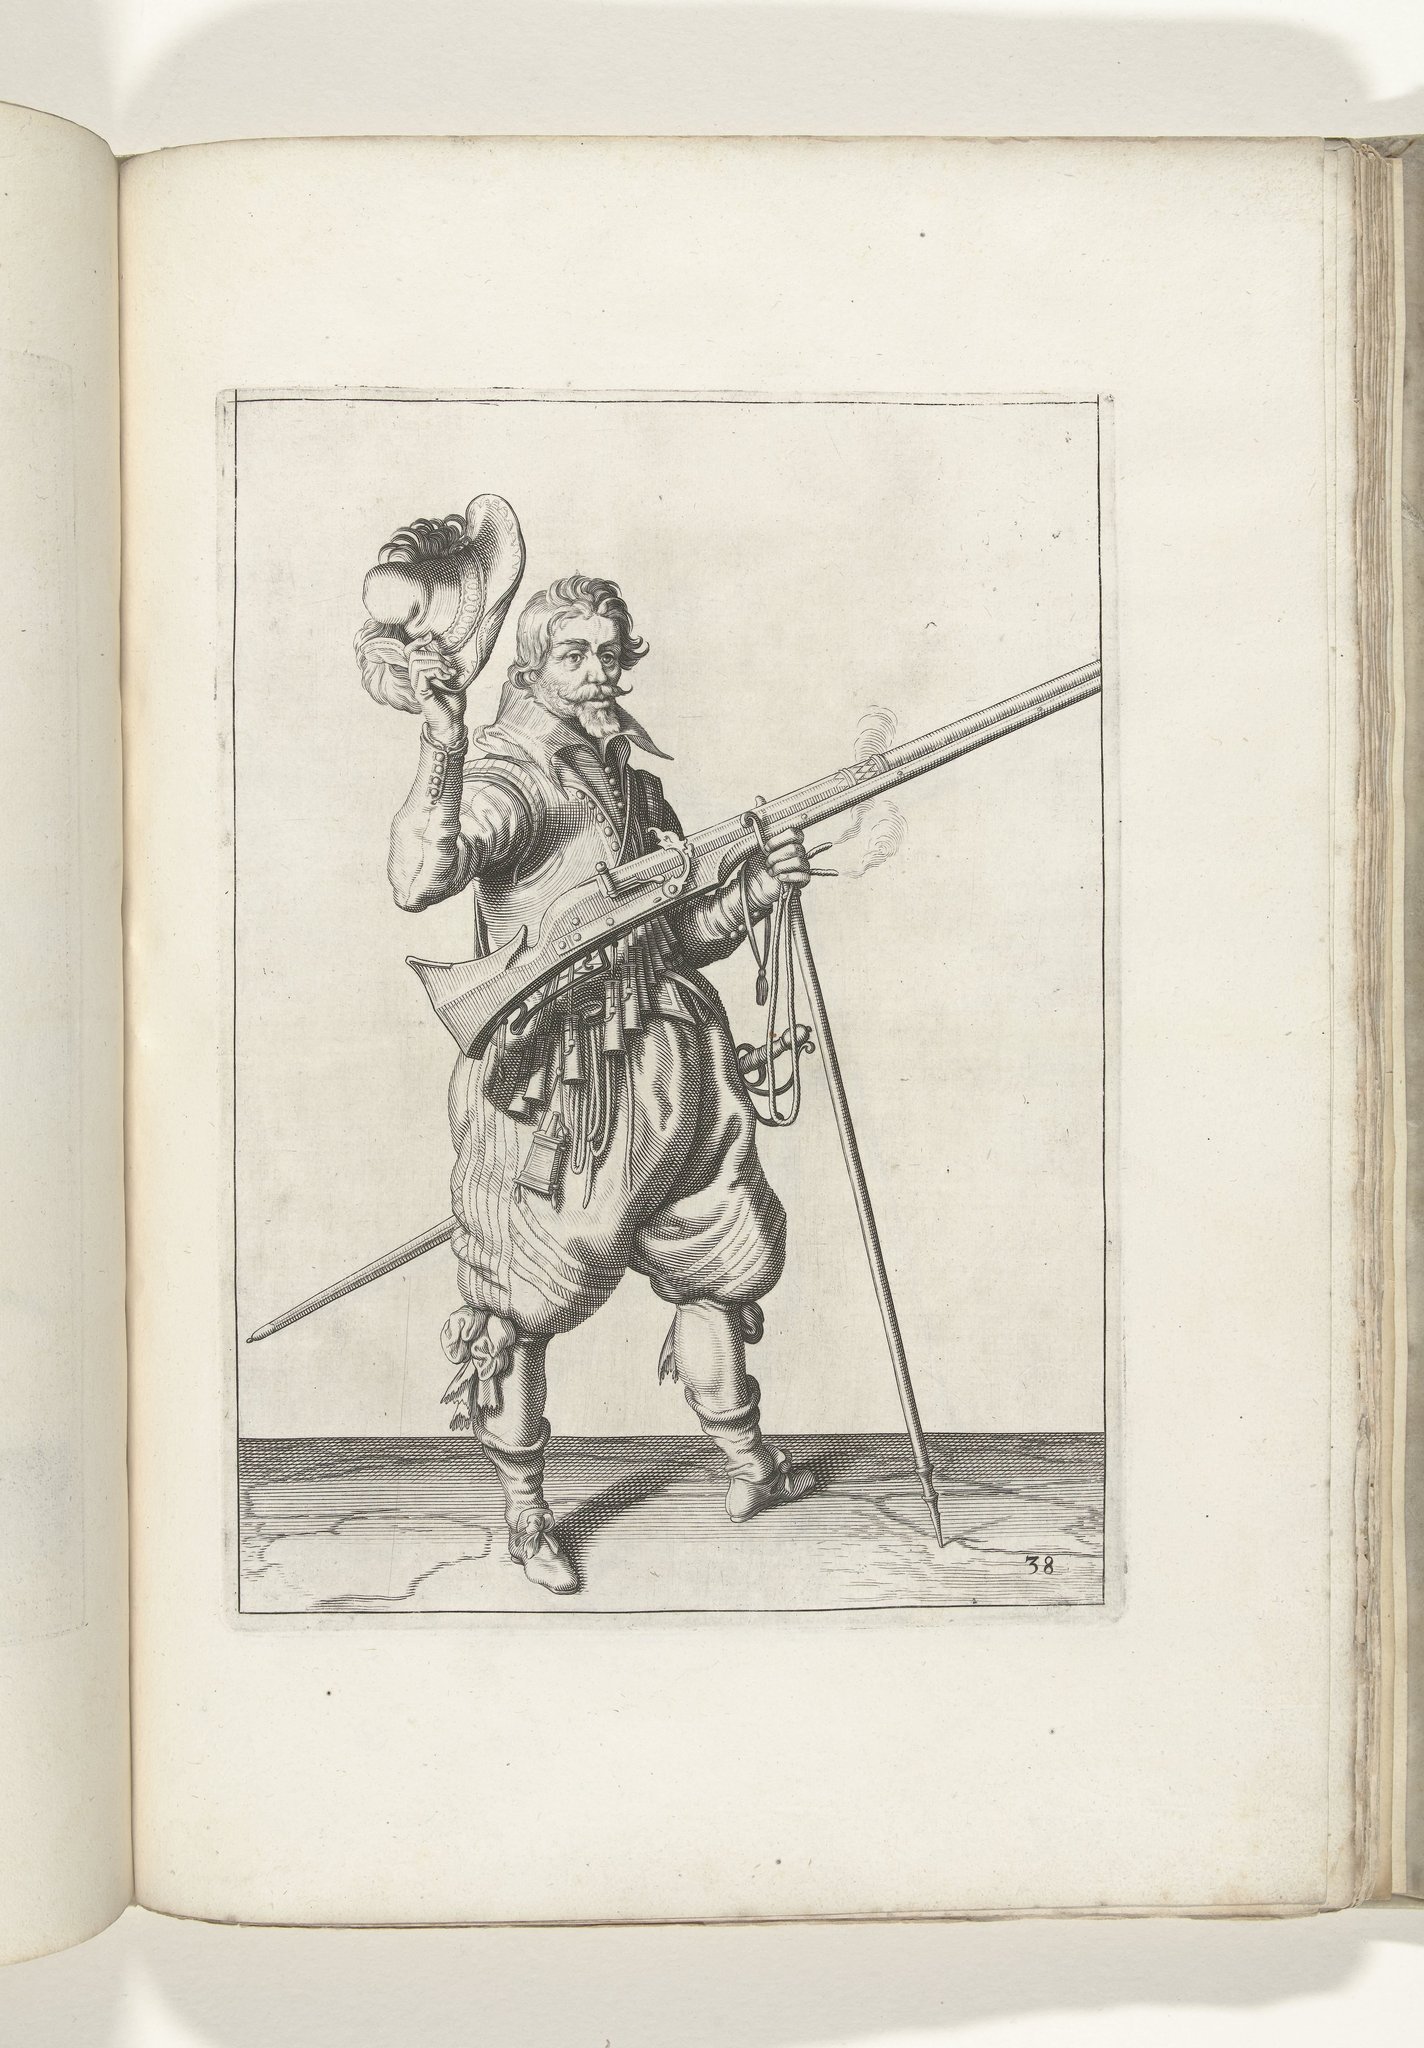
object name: print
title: Soldaat op wacht die zijn musket met zijn linkerhand bij zijn rechterzijde schuin omhoog gericht vasthoudt, terwijl hij met zijn rechterhand zijn hoed afneemt (nr. 38), ca. 1600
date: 1597-1607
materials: paper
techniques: engraving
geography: the hague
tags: maurice (prince of orange), handling of weapons ~ military training, weapons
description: Een soldaat op wacht, ten voeten uit, naar rechts, die een musket (een bepaald type vuurwapen) bij zijn rechterzijde vasthoudt, zijn linkerhand om de vork van het furket (musketvork) waarop de loop, schuin omhoog gericht, rust (nr. 38), ca. 1600. In zijn linkerhand tevens een brandende lont. Met zijn rechterhand neemt de soldaat zijn hoed af. Plaat 38 in de instructies voor het hanteren van het musket: Corte onderrechtinghe op de figuerliicke afbeeldinghe, soo veel aengaet het recht ghebruyck vant Musquet. Onderdeel van de illustraties in: J. de Gheyn, Wapenhandelinghe van Roers Musquetten ende spiessen, 's-Gravenhage, 1607. Krijgswezen rond 1600.